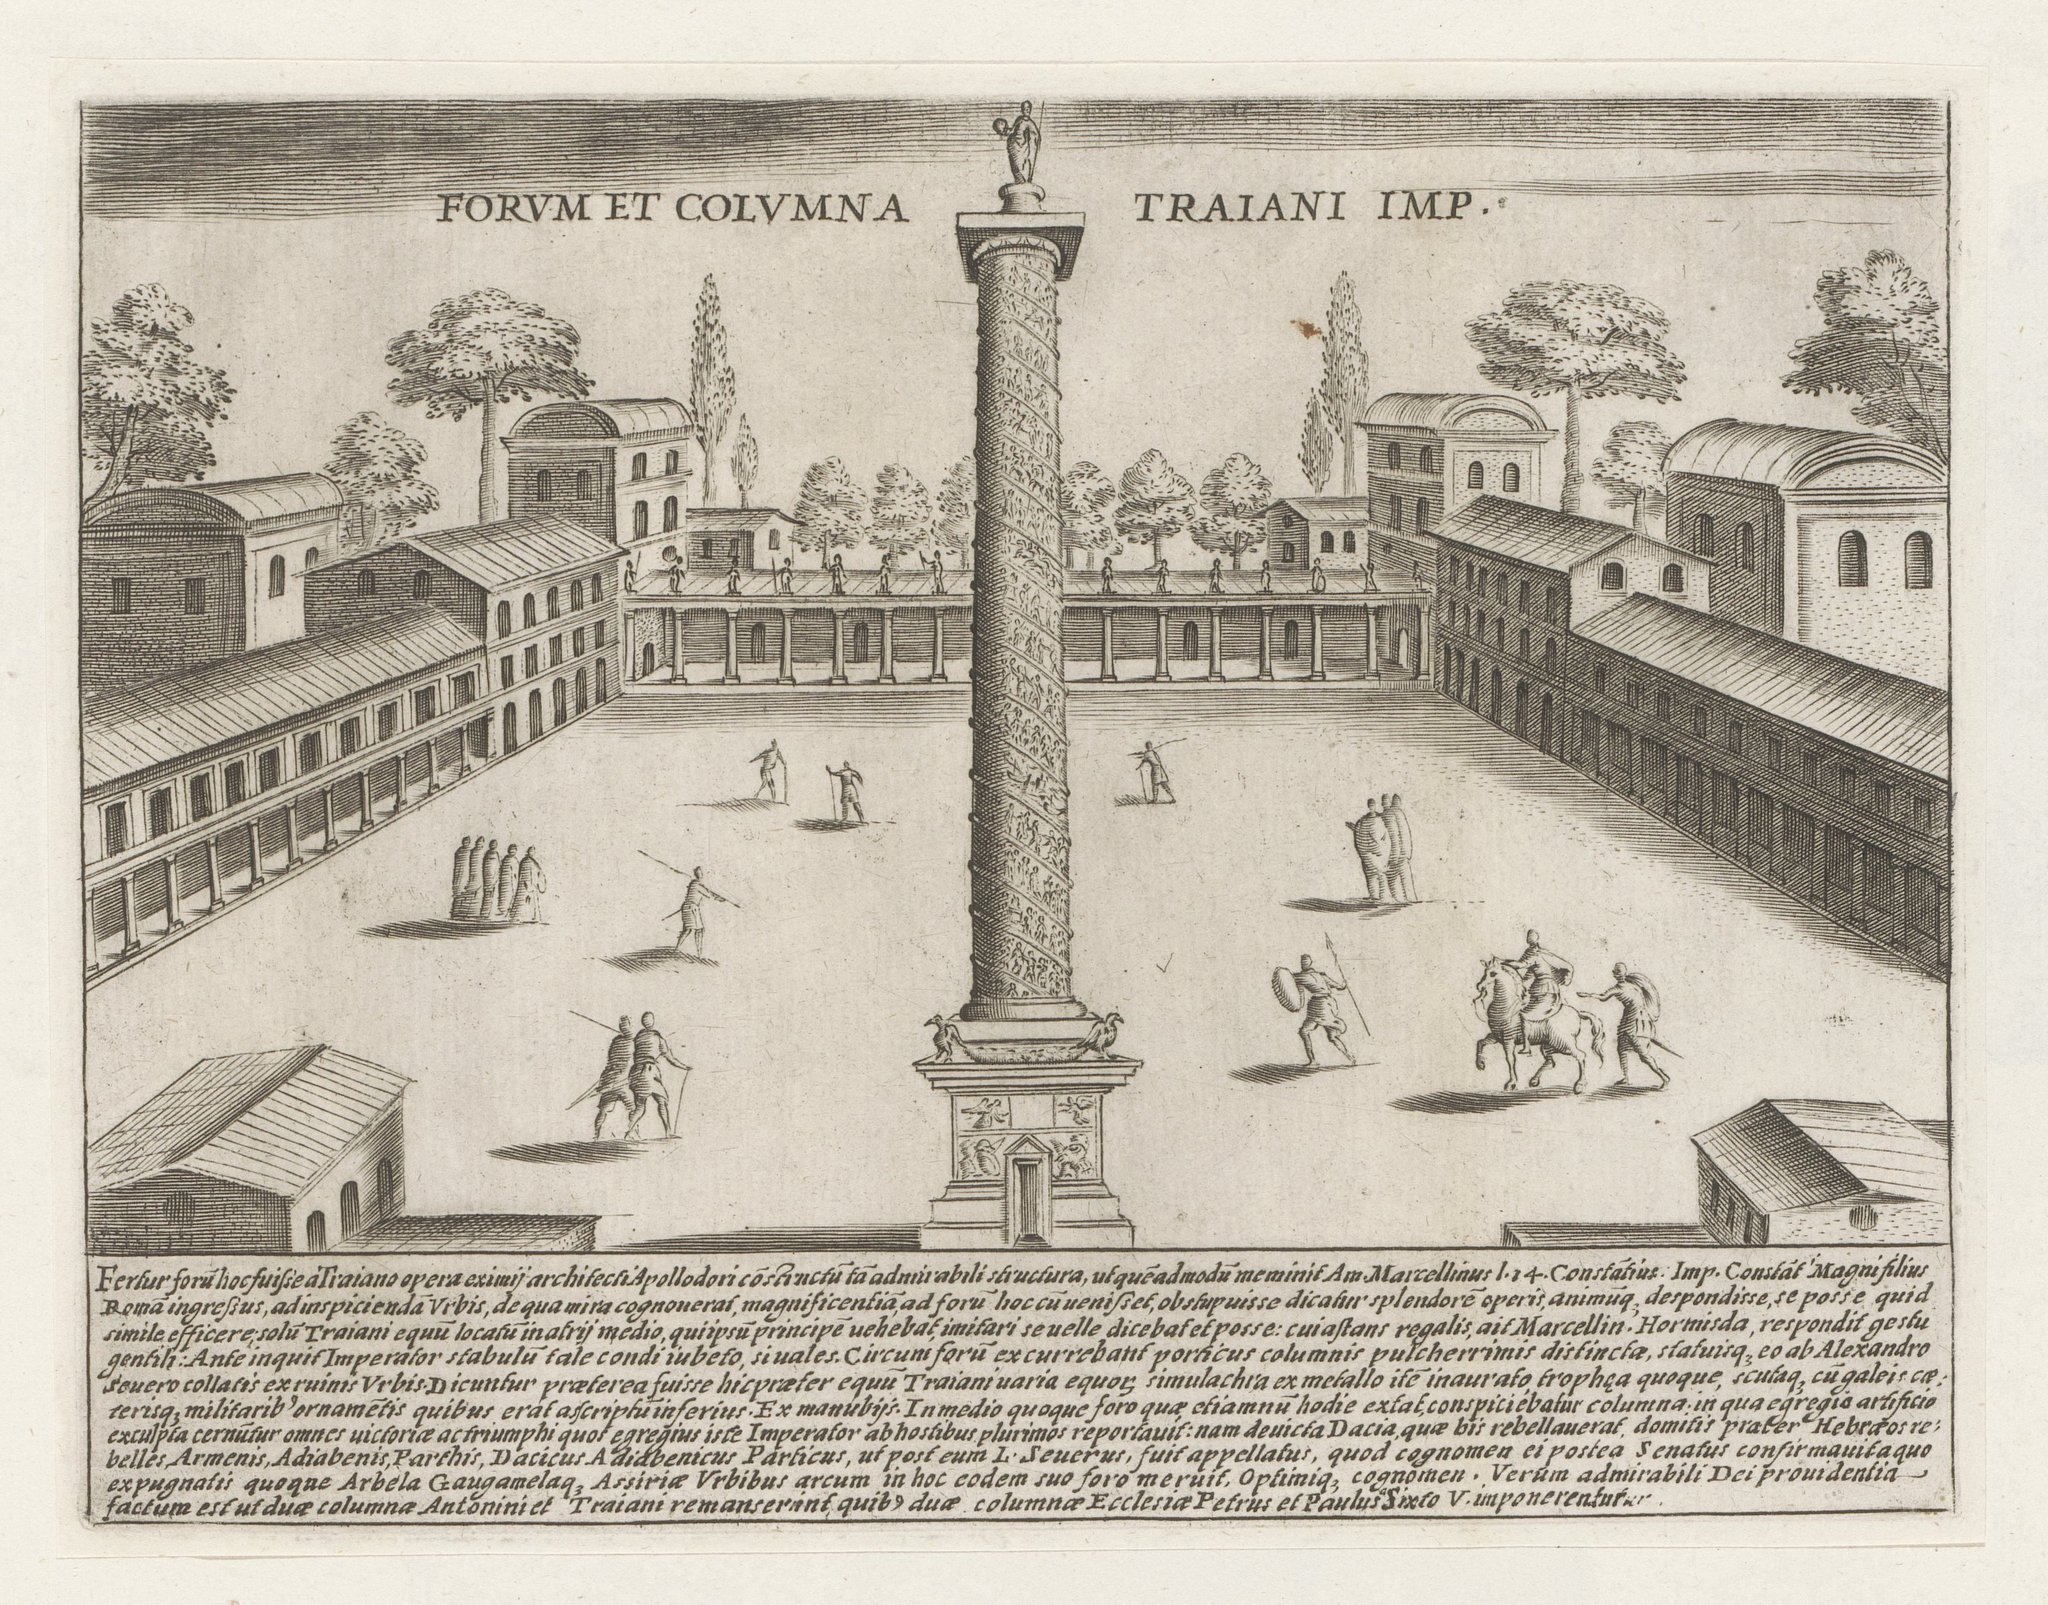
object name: album leaf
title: Forum en de Zuil van Trajanus te Rome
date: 1612-1628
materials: paper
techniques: etching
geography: rome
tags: square, place, circus, etc., triumphal column with helical friezes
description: Deze prent maakt deel uit van een set van 158 prenten (+ titelprenten), die verscheen in vier delen. In 1612 verschenen delen één en twee. In 1615 verscheen het derde deel en in 1628 verscheen deel vier. In 1637 publiceerde Vitale Mascardi de eerste heruitgave van de gehele set met nummering.